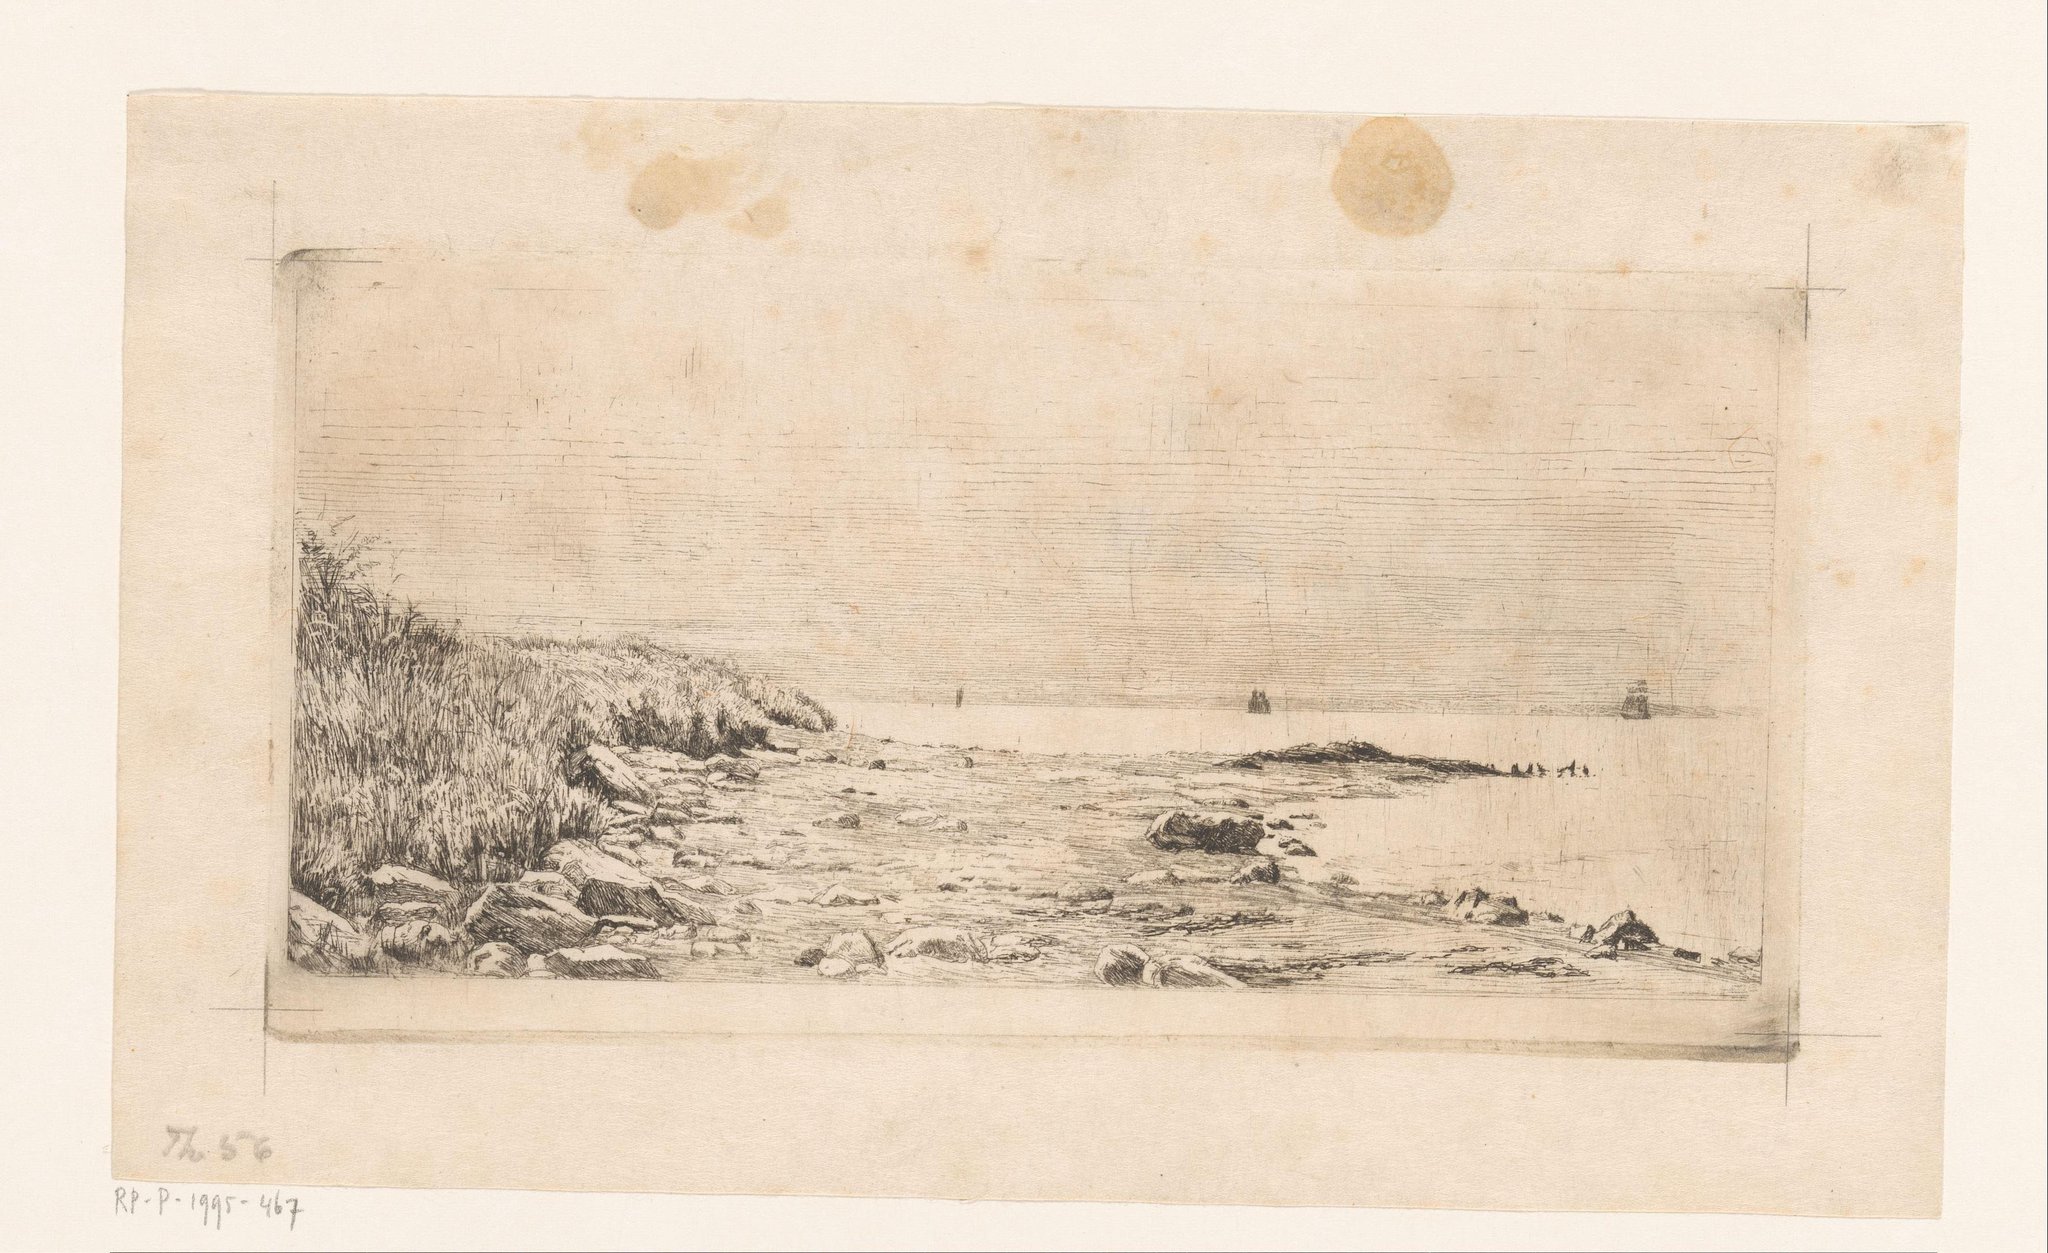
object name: print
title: Duin aan zee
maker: carl bloch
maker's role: print maker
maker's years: 1834-1890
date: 1884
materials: paper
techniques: drypoint, etching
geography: scandinavia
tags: rocky coast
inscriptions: collector's mark: Lugt 2228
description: Links een stuk lage duin, uitlopend in stukje strand met stenen. Rechts de zee met, in de verte, drie zeilschepen.